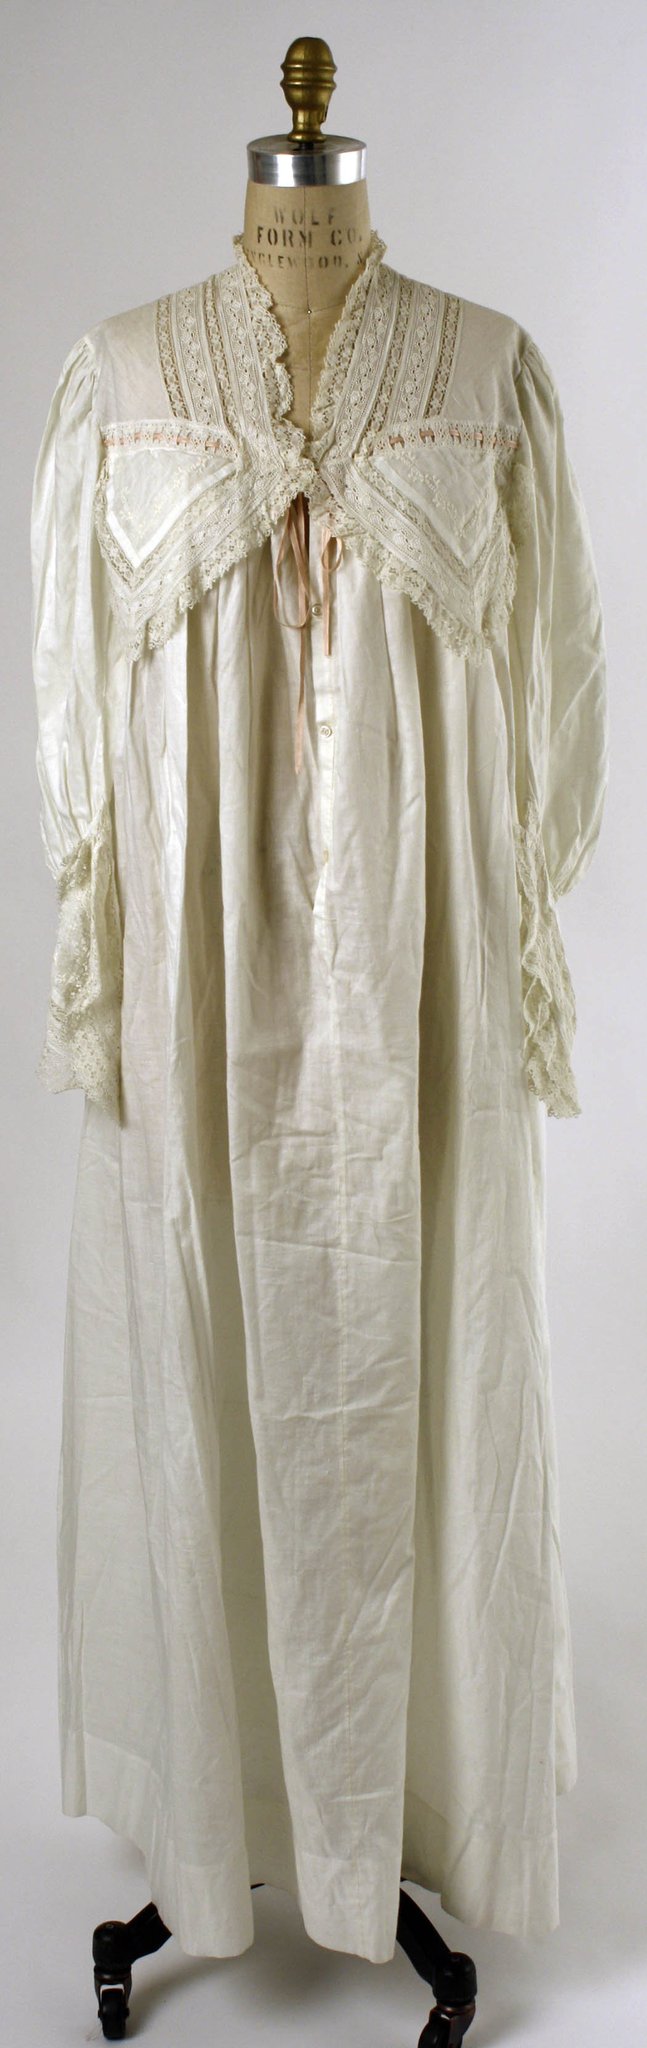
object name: nightgown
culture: american or european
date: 1880-1889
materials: cotton